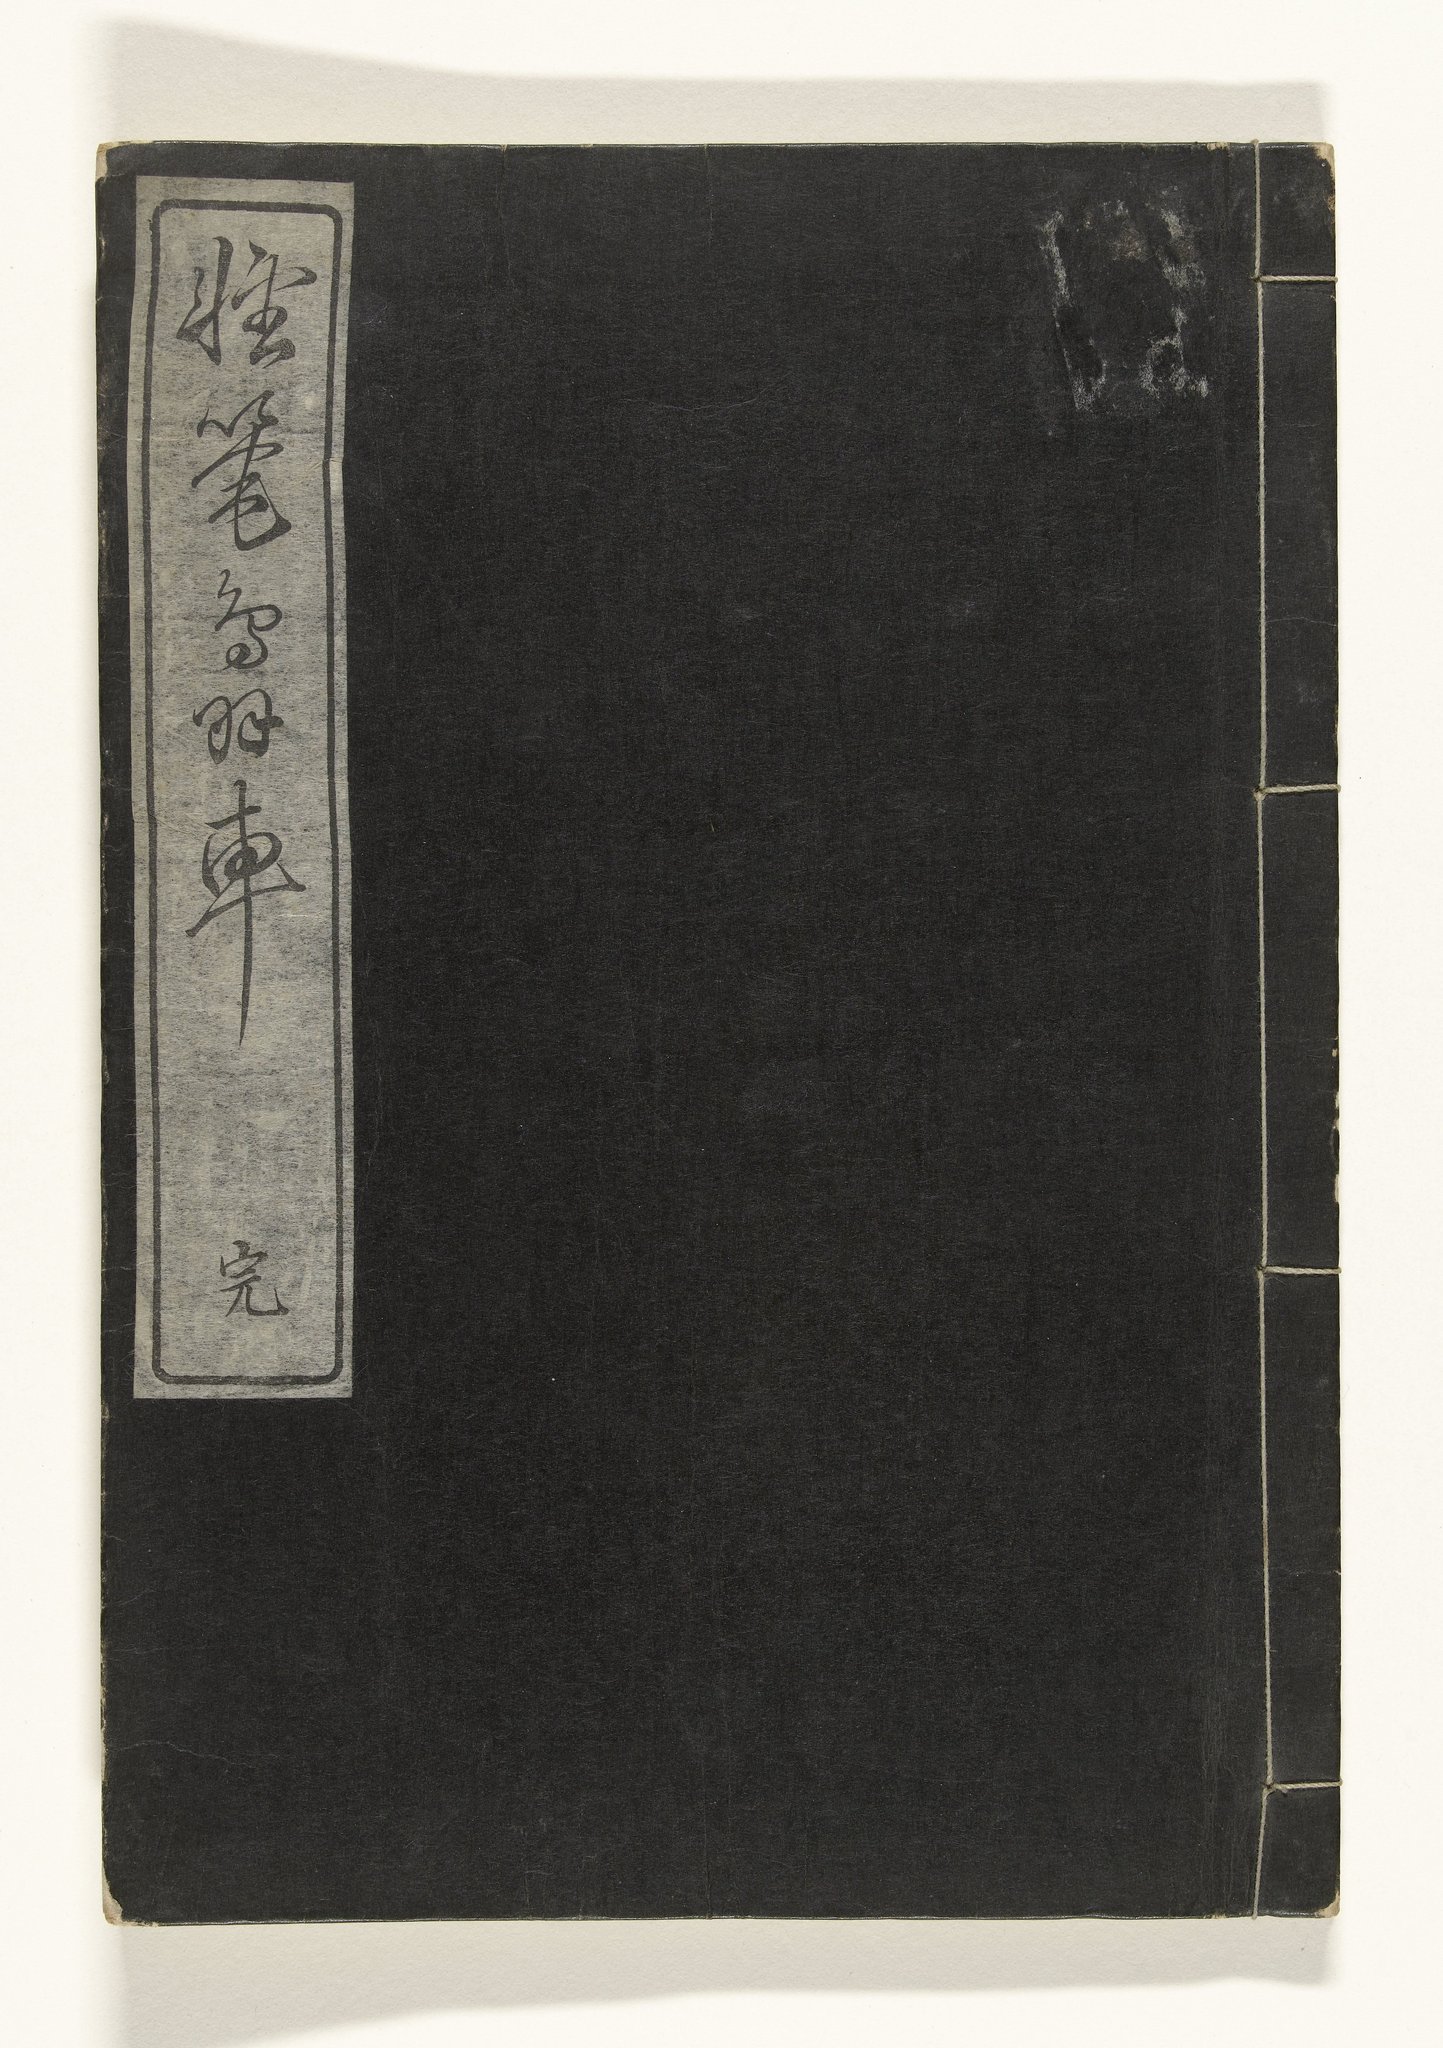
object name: book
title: Keihitsu tobaguruma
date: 1752-1800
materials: paper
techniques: woodcut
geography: japan